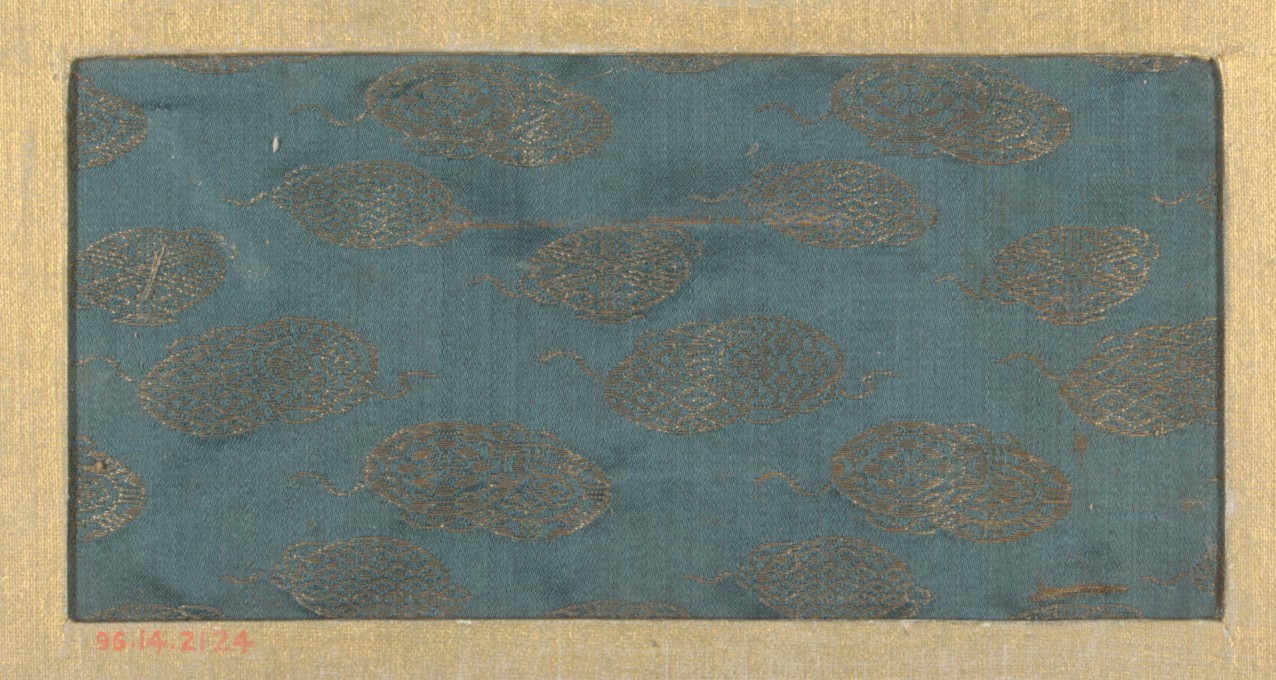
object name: piece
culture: japanese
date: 1701-1900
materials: silk